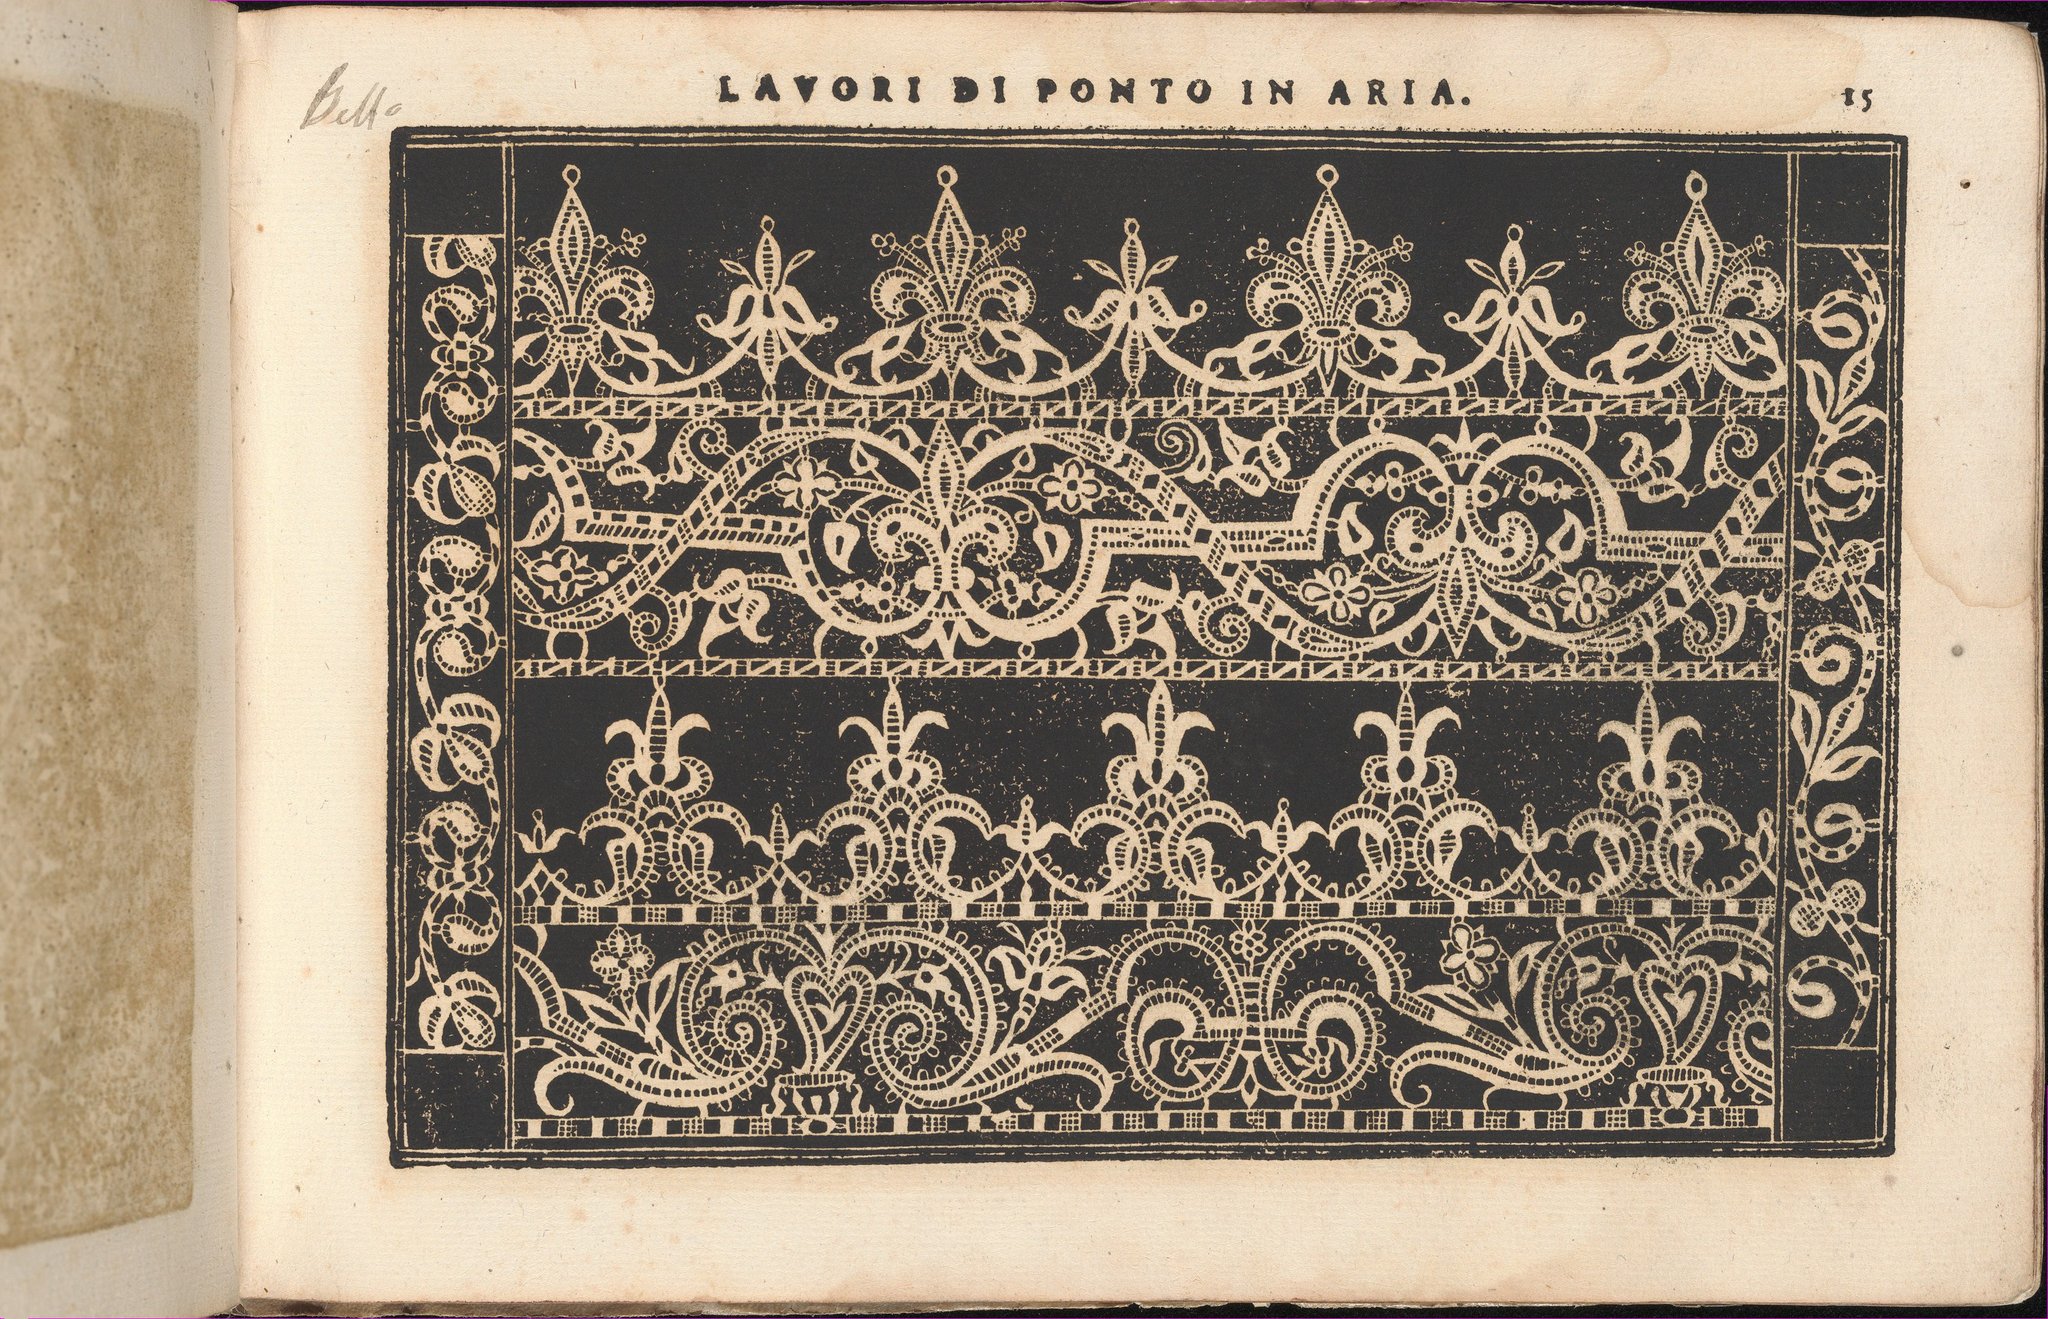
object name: book print ornament architecture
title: Teatro delle Nobili et Virtuose Donne..., page 23 (recto)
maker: isabella catanea parasole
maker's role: author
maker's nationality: italian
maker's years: 1565-1625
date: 1616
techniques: engraving, woodcut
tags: ornament